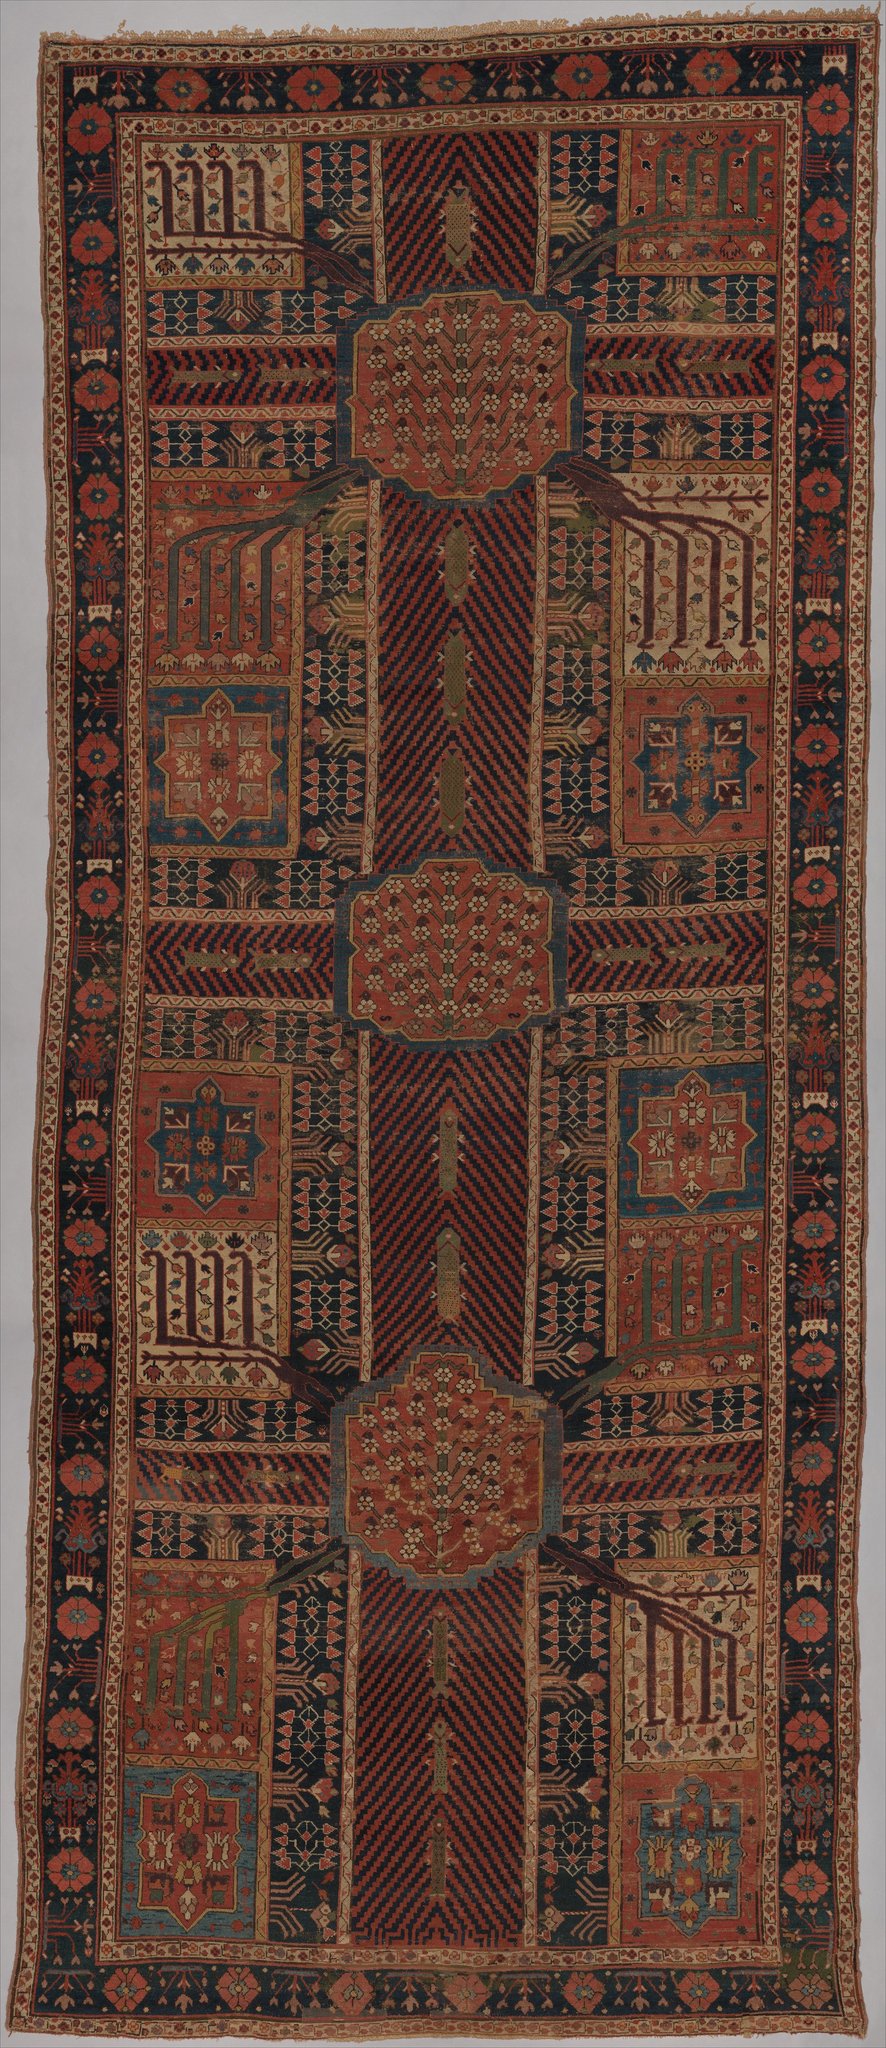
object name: carpet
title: Garden Carpet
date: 1800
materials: cotton, wool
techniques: pile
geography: iran